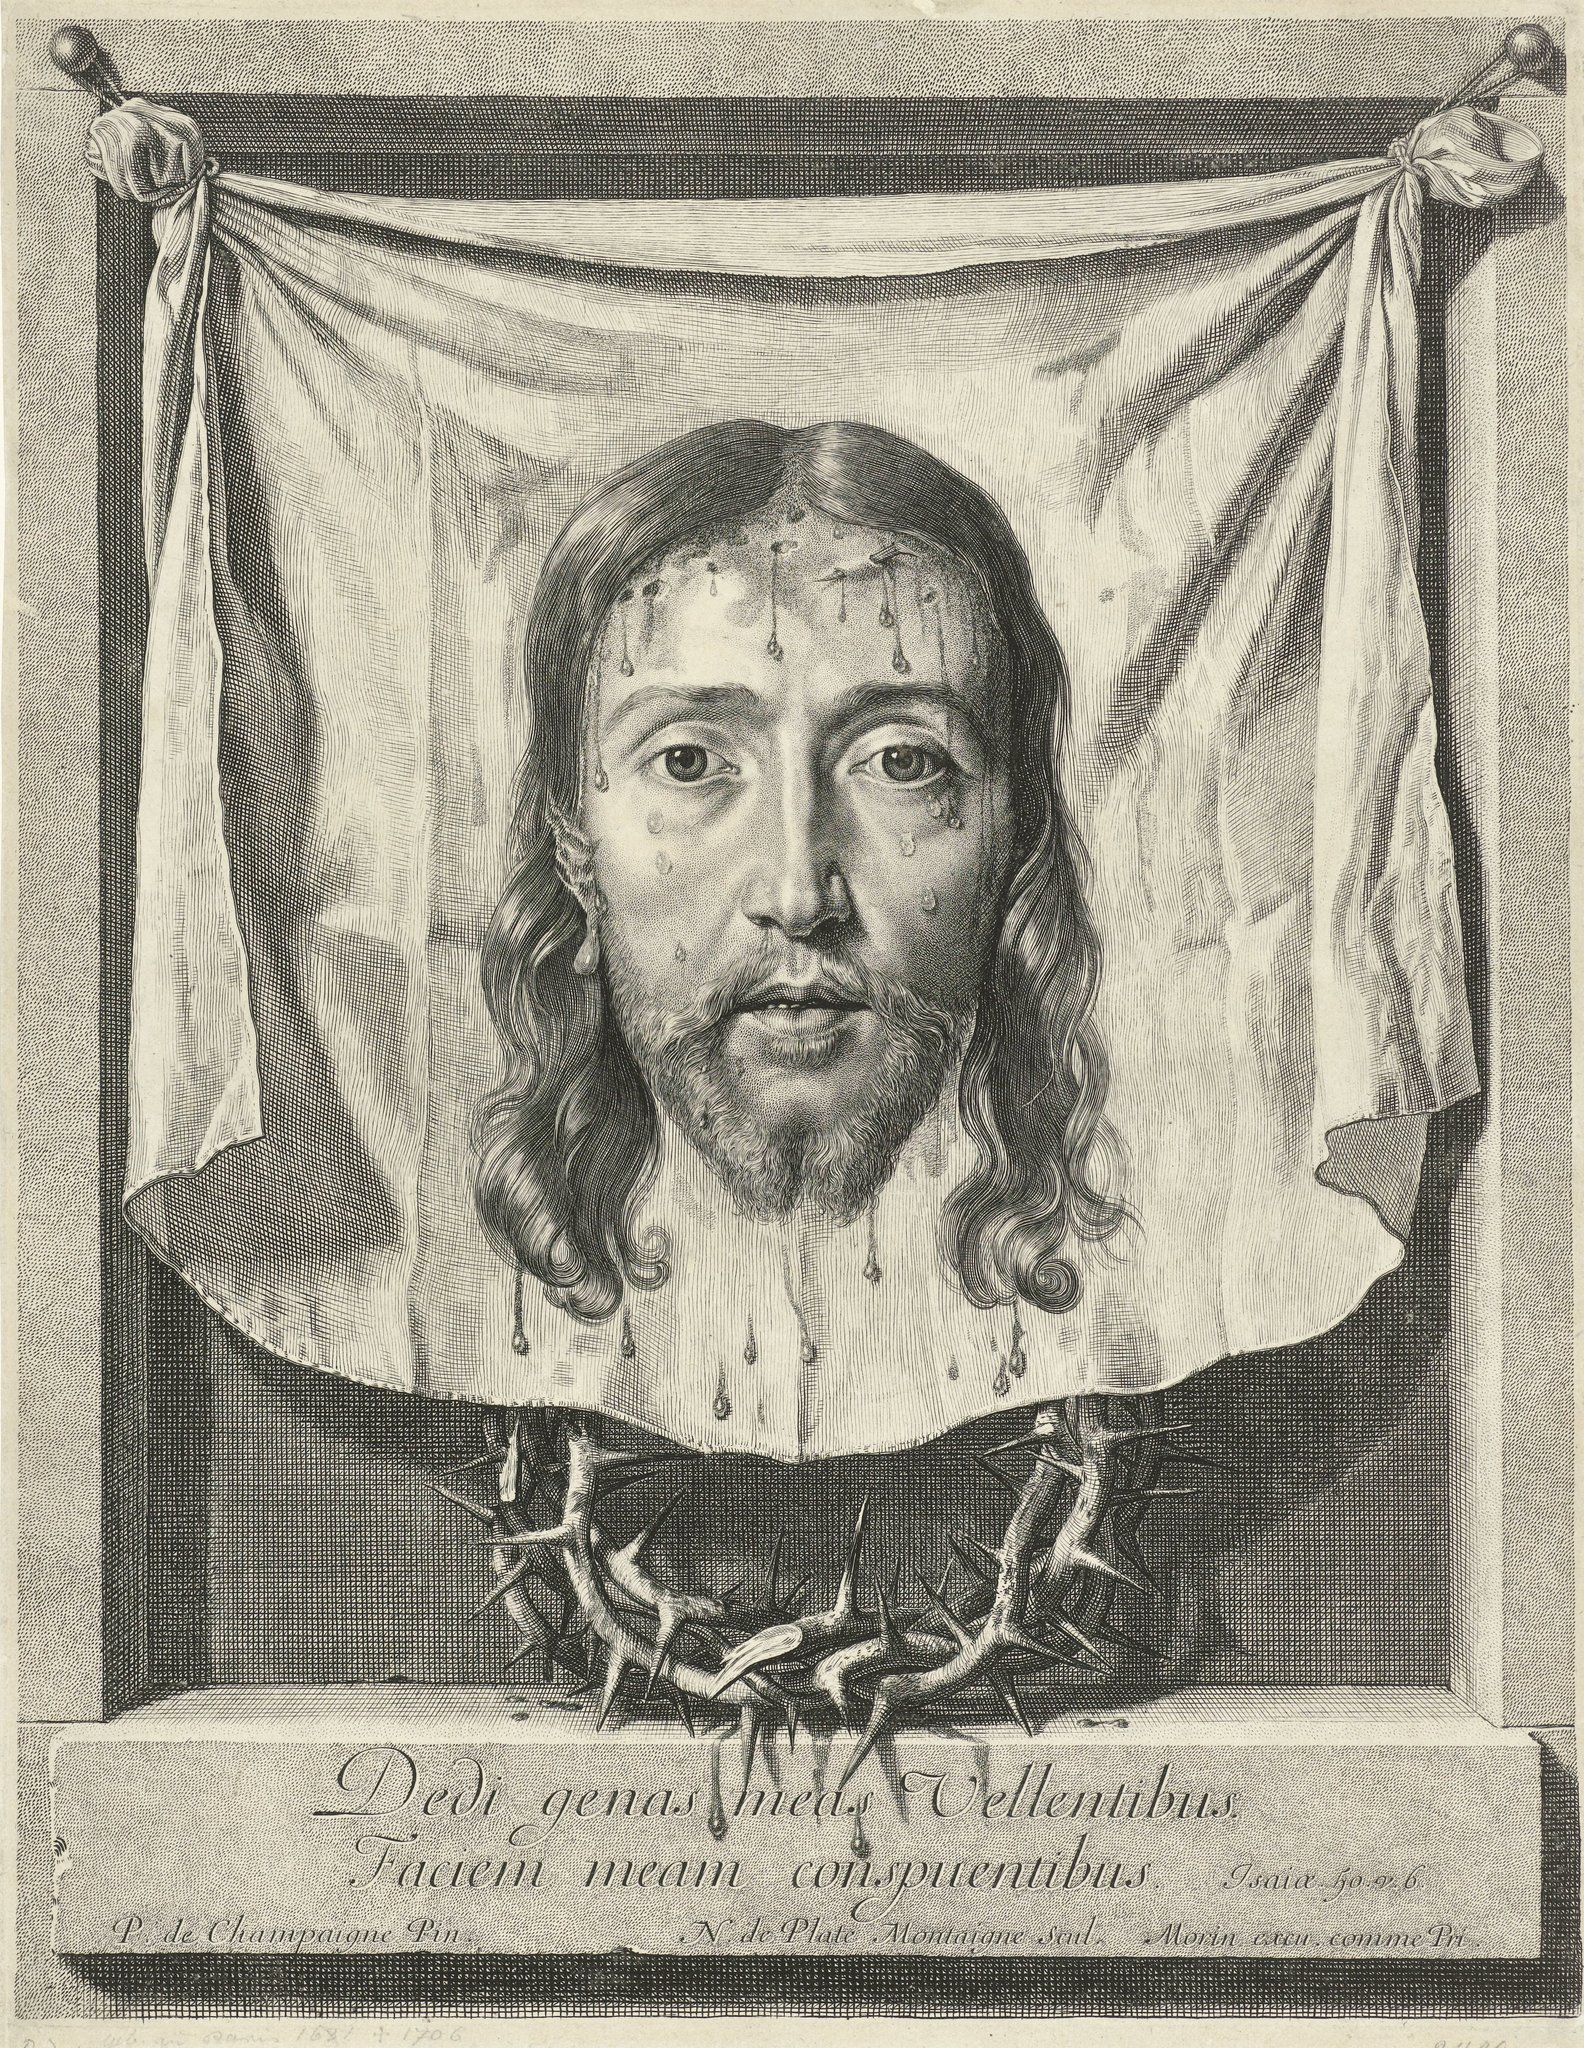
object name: print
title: Sudarium van H. Veronica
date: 1650-1706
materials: paper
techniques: engraving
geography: paris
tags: crown of thorns ~ instruments of the passion, 'vera icon', 'sudarium', veronica-portrait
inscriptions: collector's mark: Lugt 2228, collector's mark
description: De zweetdoek van de Heilige Veronica waarop de afdruk van het gelaat van Christus. Onder de doek de doornenkroon. In de marge een Bijbelcitaat uit Jes. 50:6 in het Latijn.